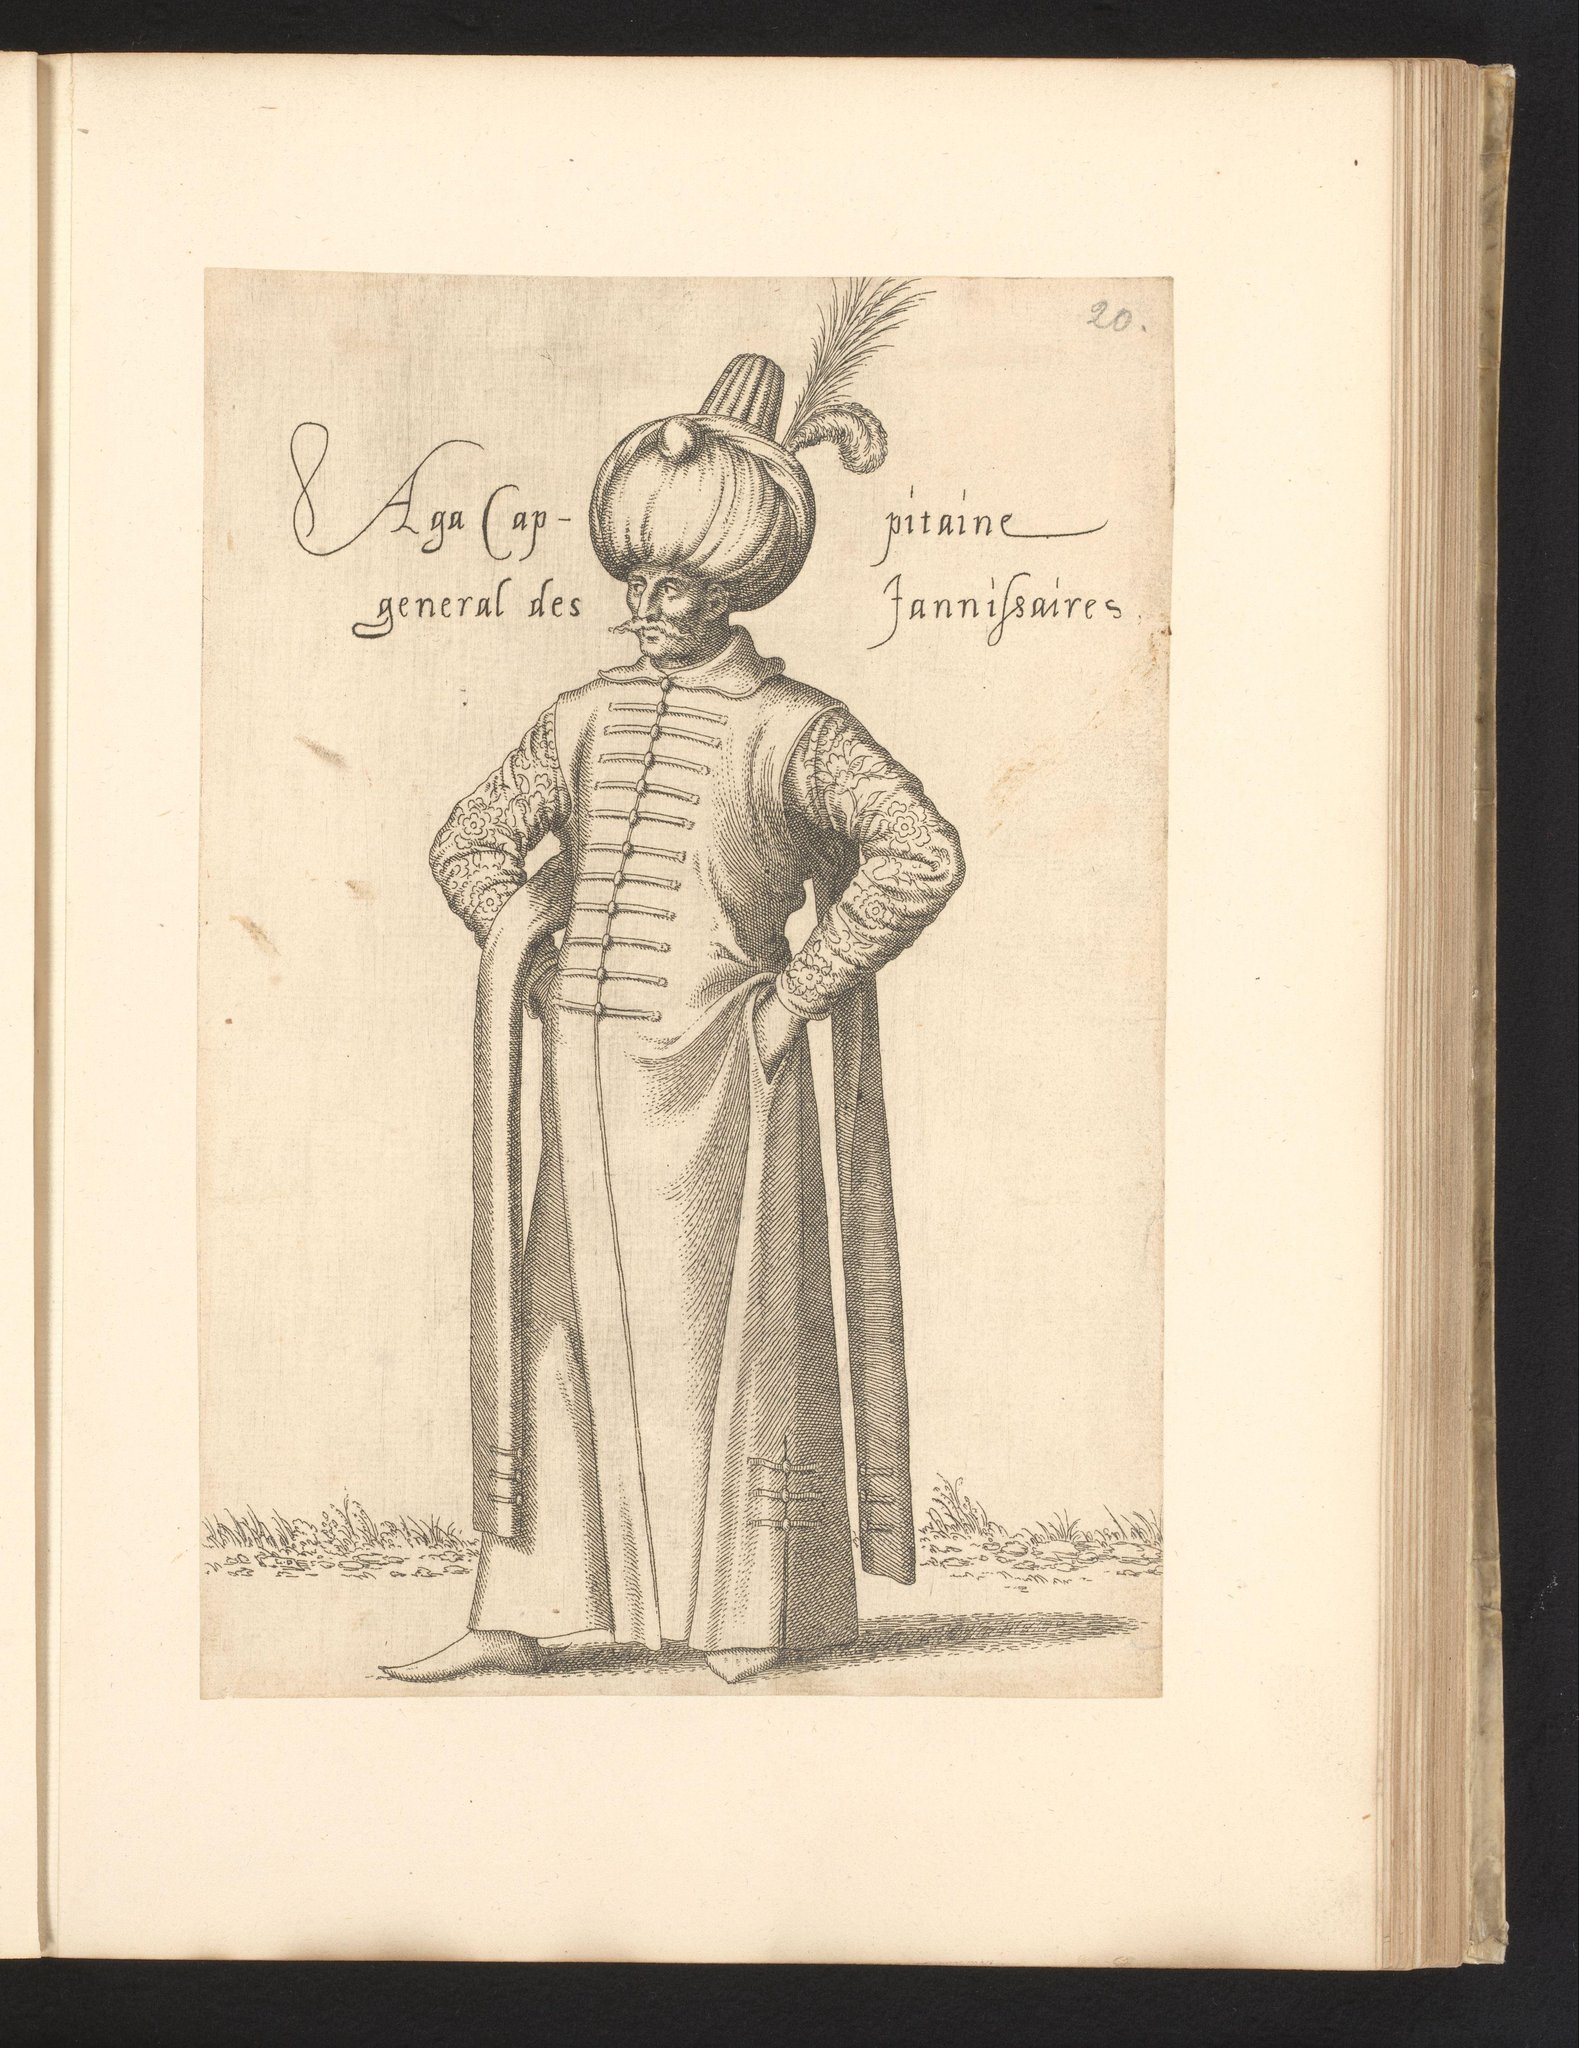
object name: album leaf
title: 'Aga' (opperbevelhebber) der janitsaren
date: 1555-1568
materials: paper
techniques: etching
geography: lyon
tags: commander-in-chief, general, marshal, head-gear: turban, asiatic races and peoples: turks (+ costume)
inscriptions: collector's mark: Lugt 2228, collector's mark: Lugt 2760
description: Prent uit: Nicolay, Nicolas de. Les quatre premiers livres des navigations et pérégrinations orientales, de N. de Nicolay, (...) Avec les figures au naturel tant d'hommes que de femmes selon la diversité des nations, & de leur port, maintien & habitz. Lyon: Guillaume (I) Rouille, 1568.